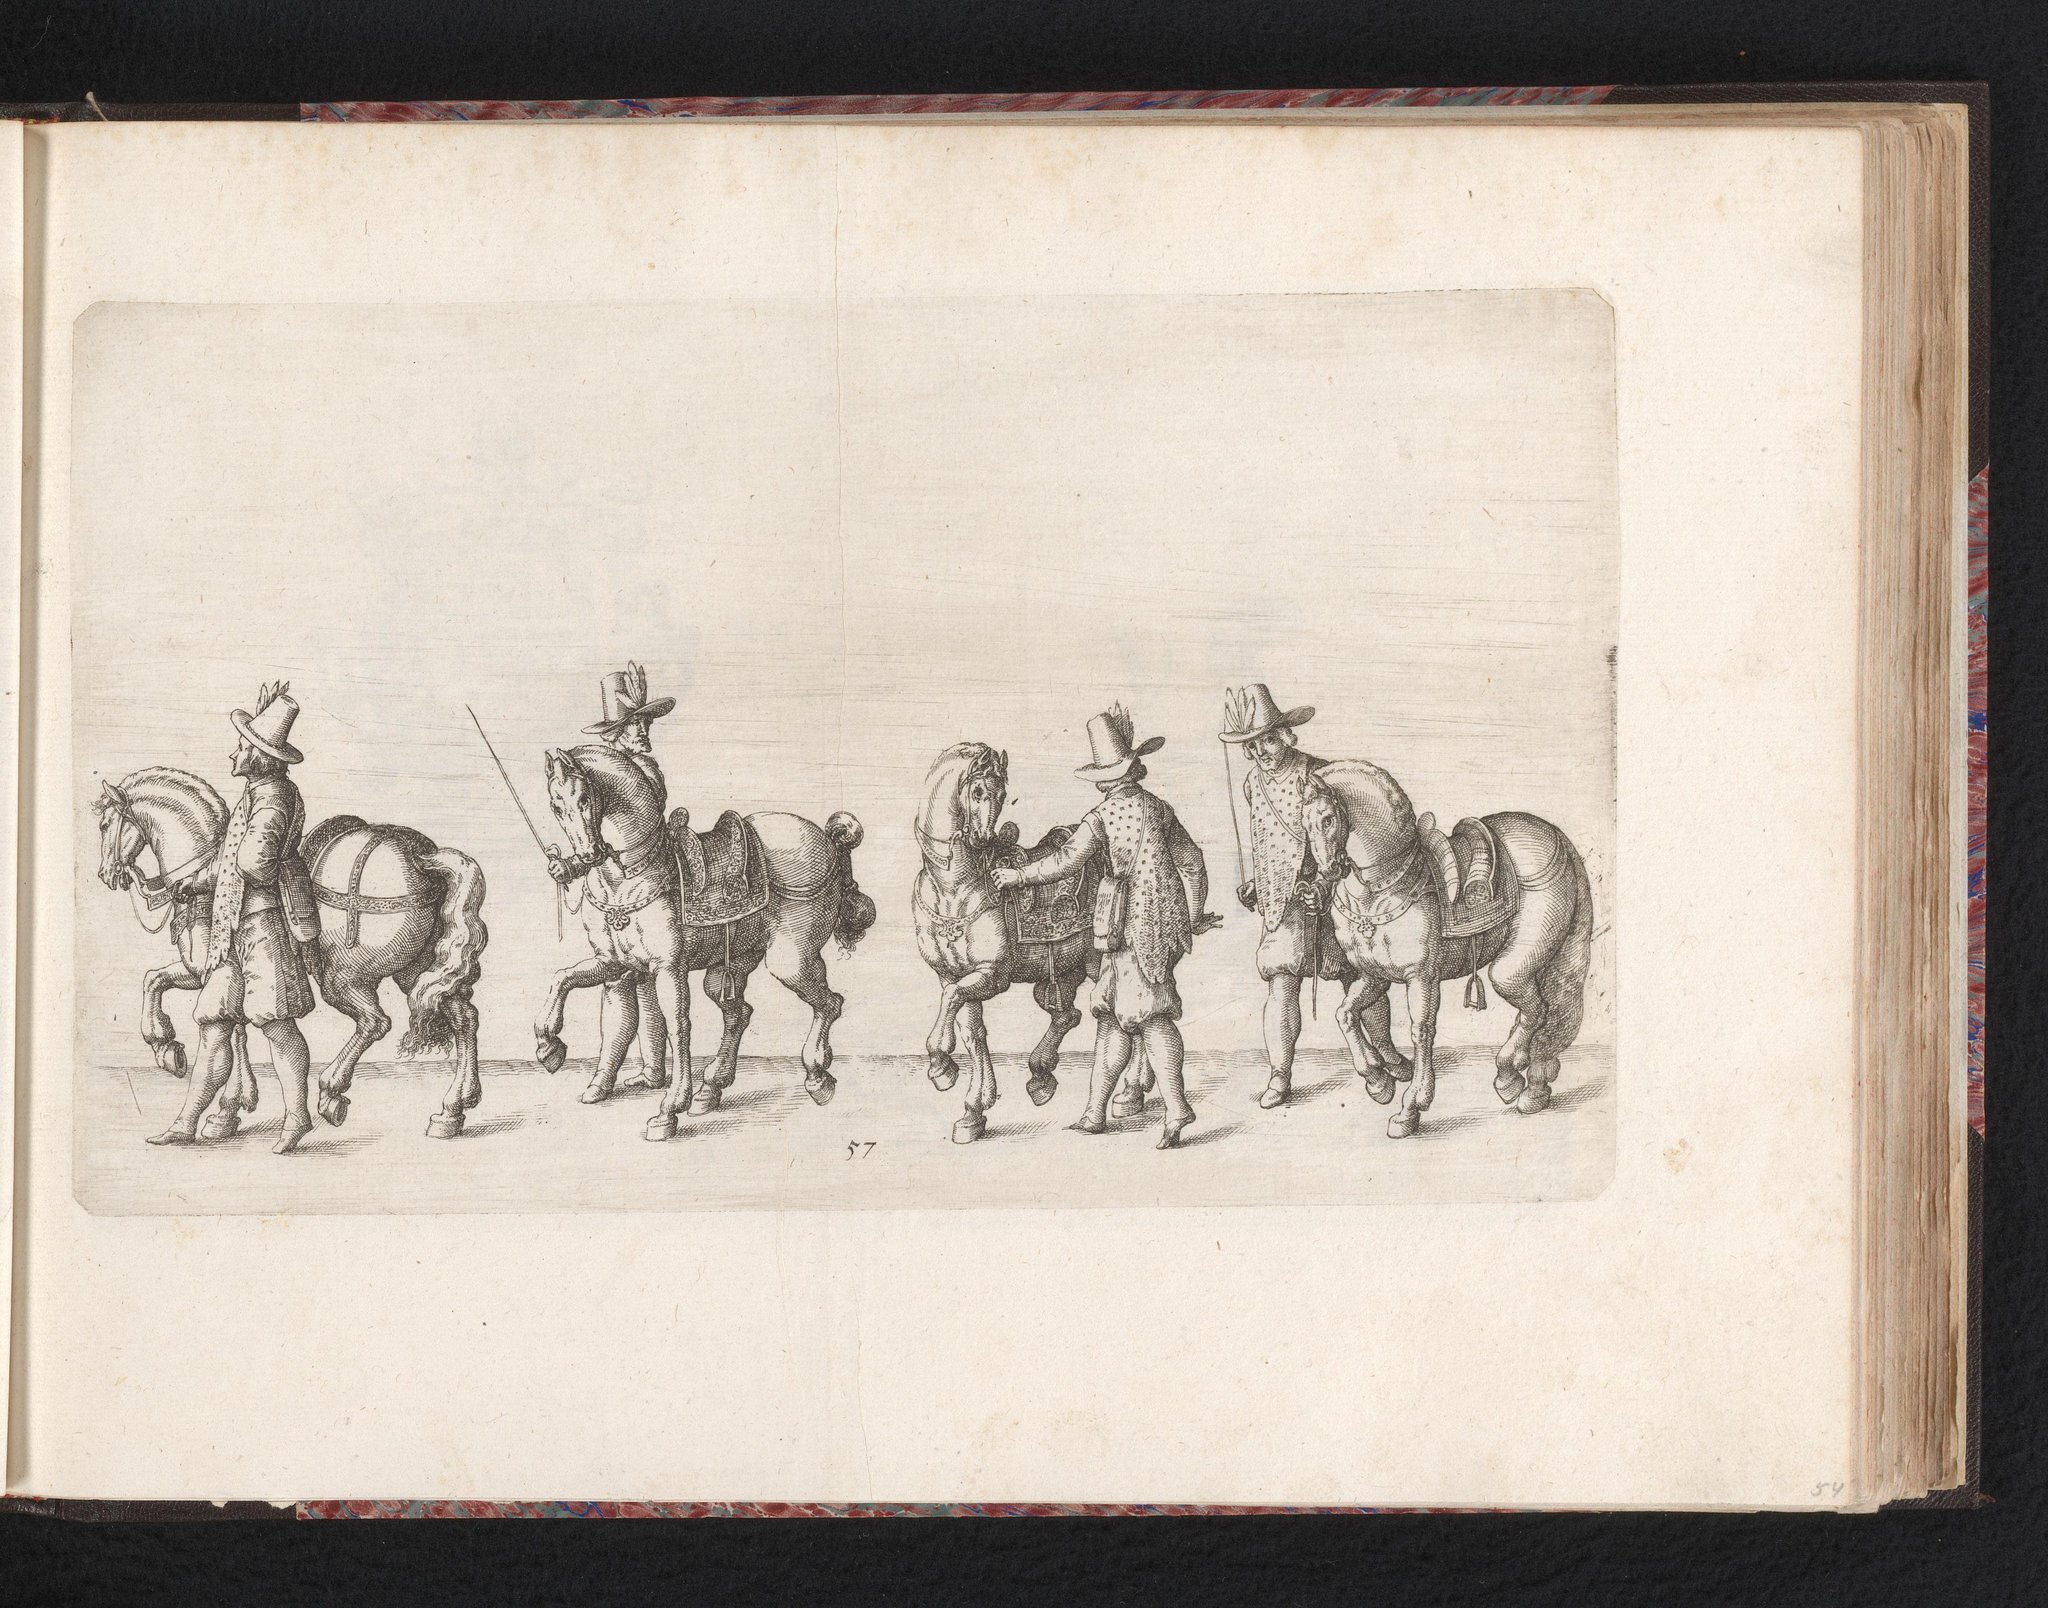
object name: print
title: Optochten en ruiterspelen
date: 1618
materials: paper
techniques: etching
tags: performance in the open air (pleasure fair), walking the dog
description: Genummerd: 56. Deze prent maakt deel uit van een album.